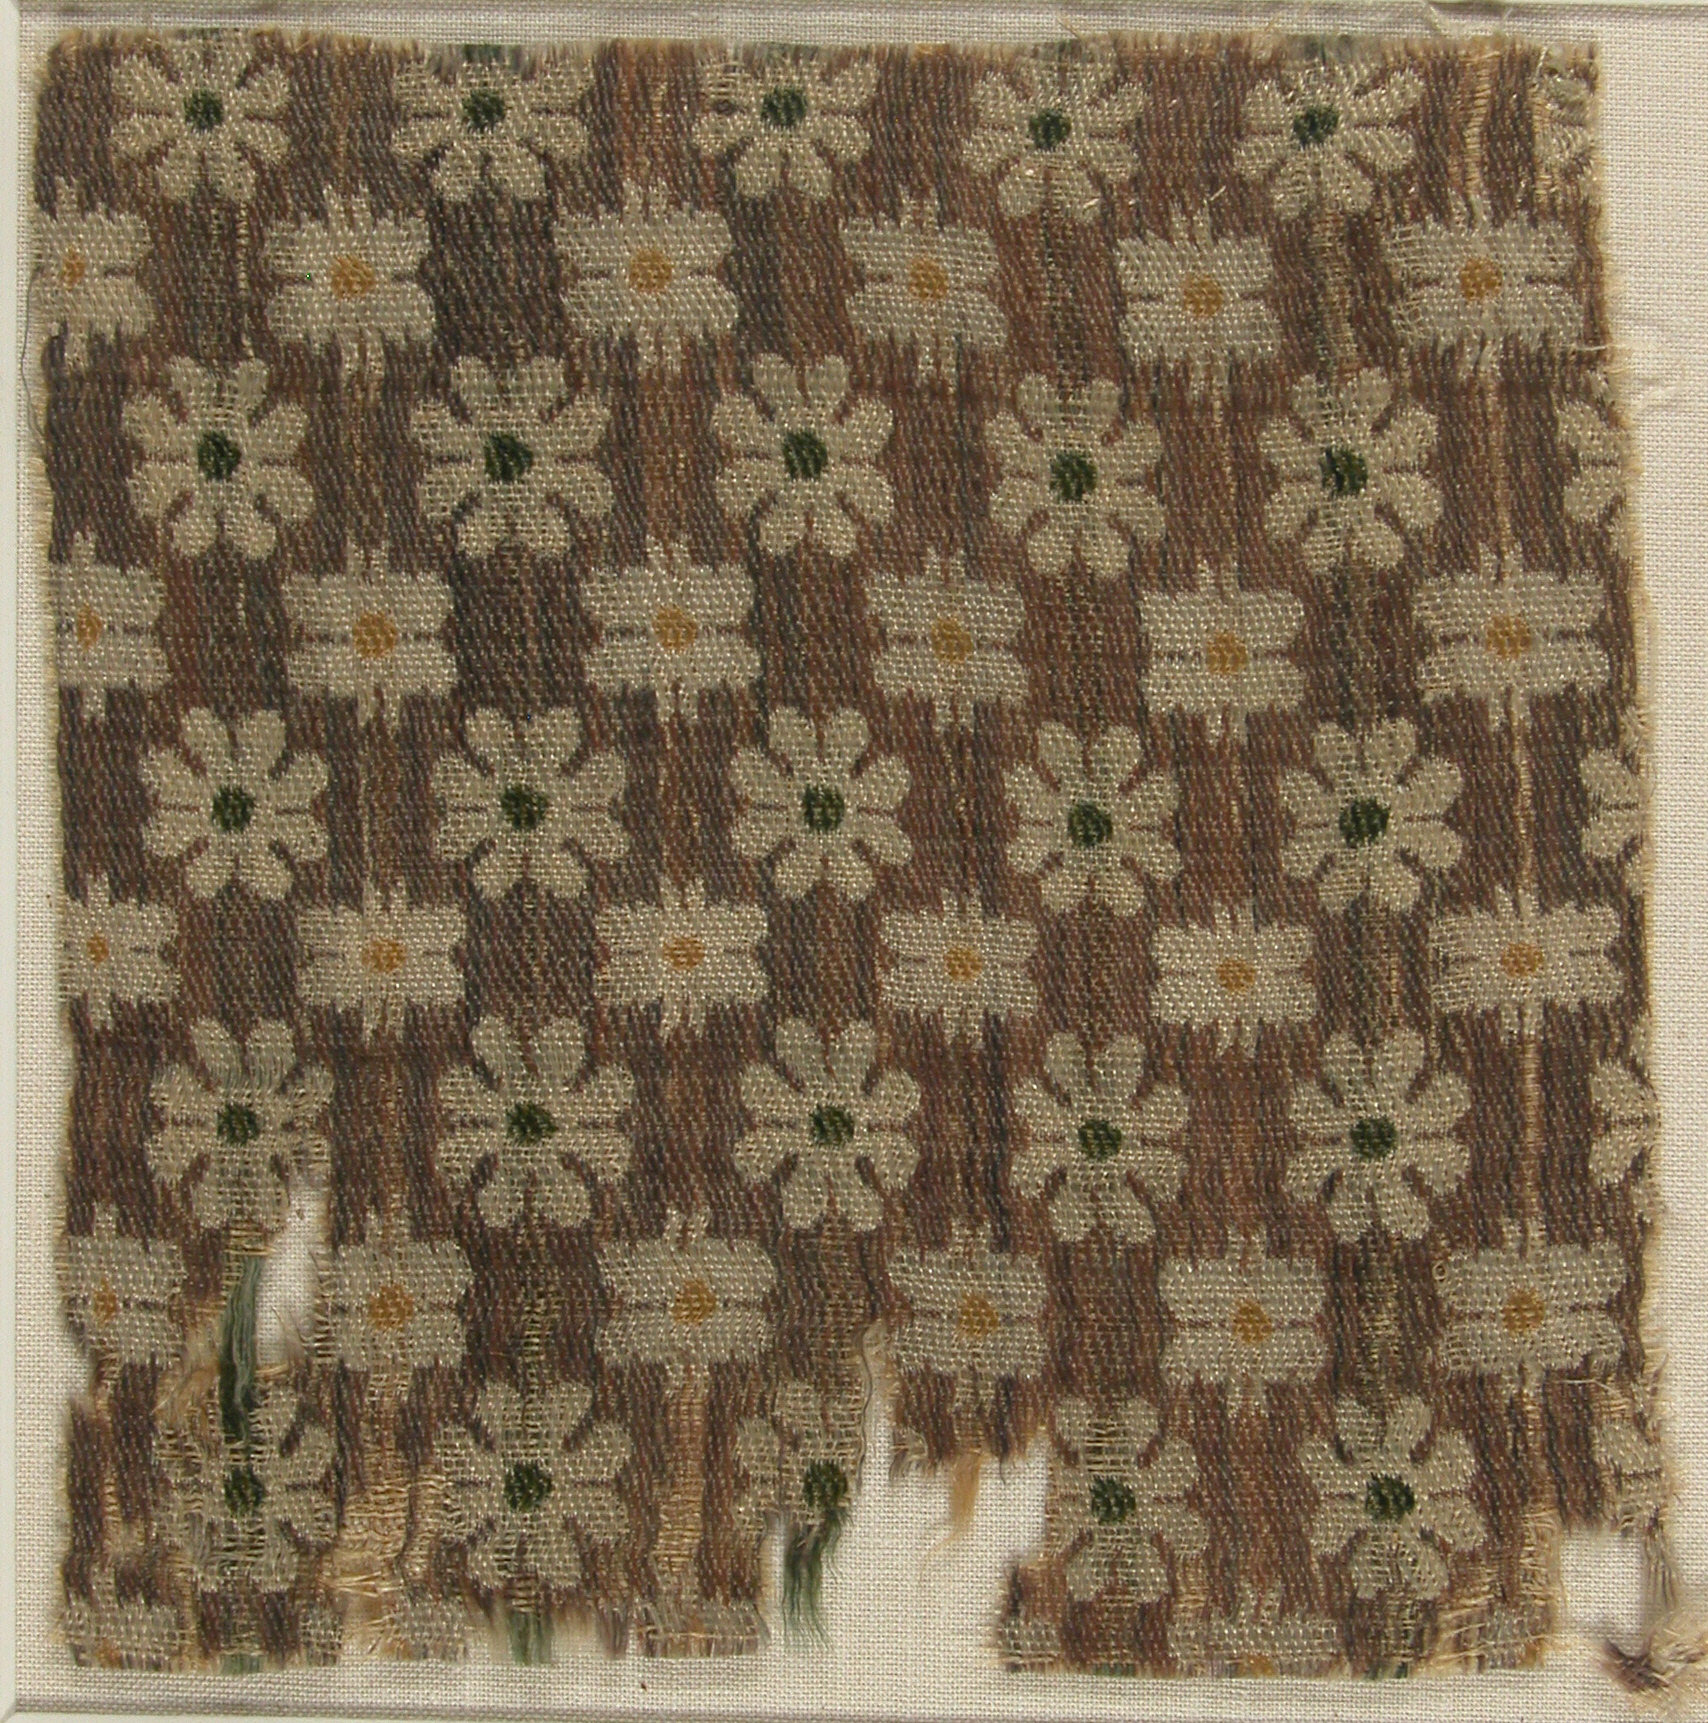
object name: textile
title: Textile with Flower Motif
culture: german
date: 1401-1500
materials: silk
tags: flowers